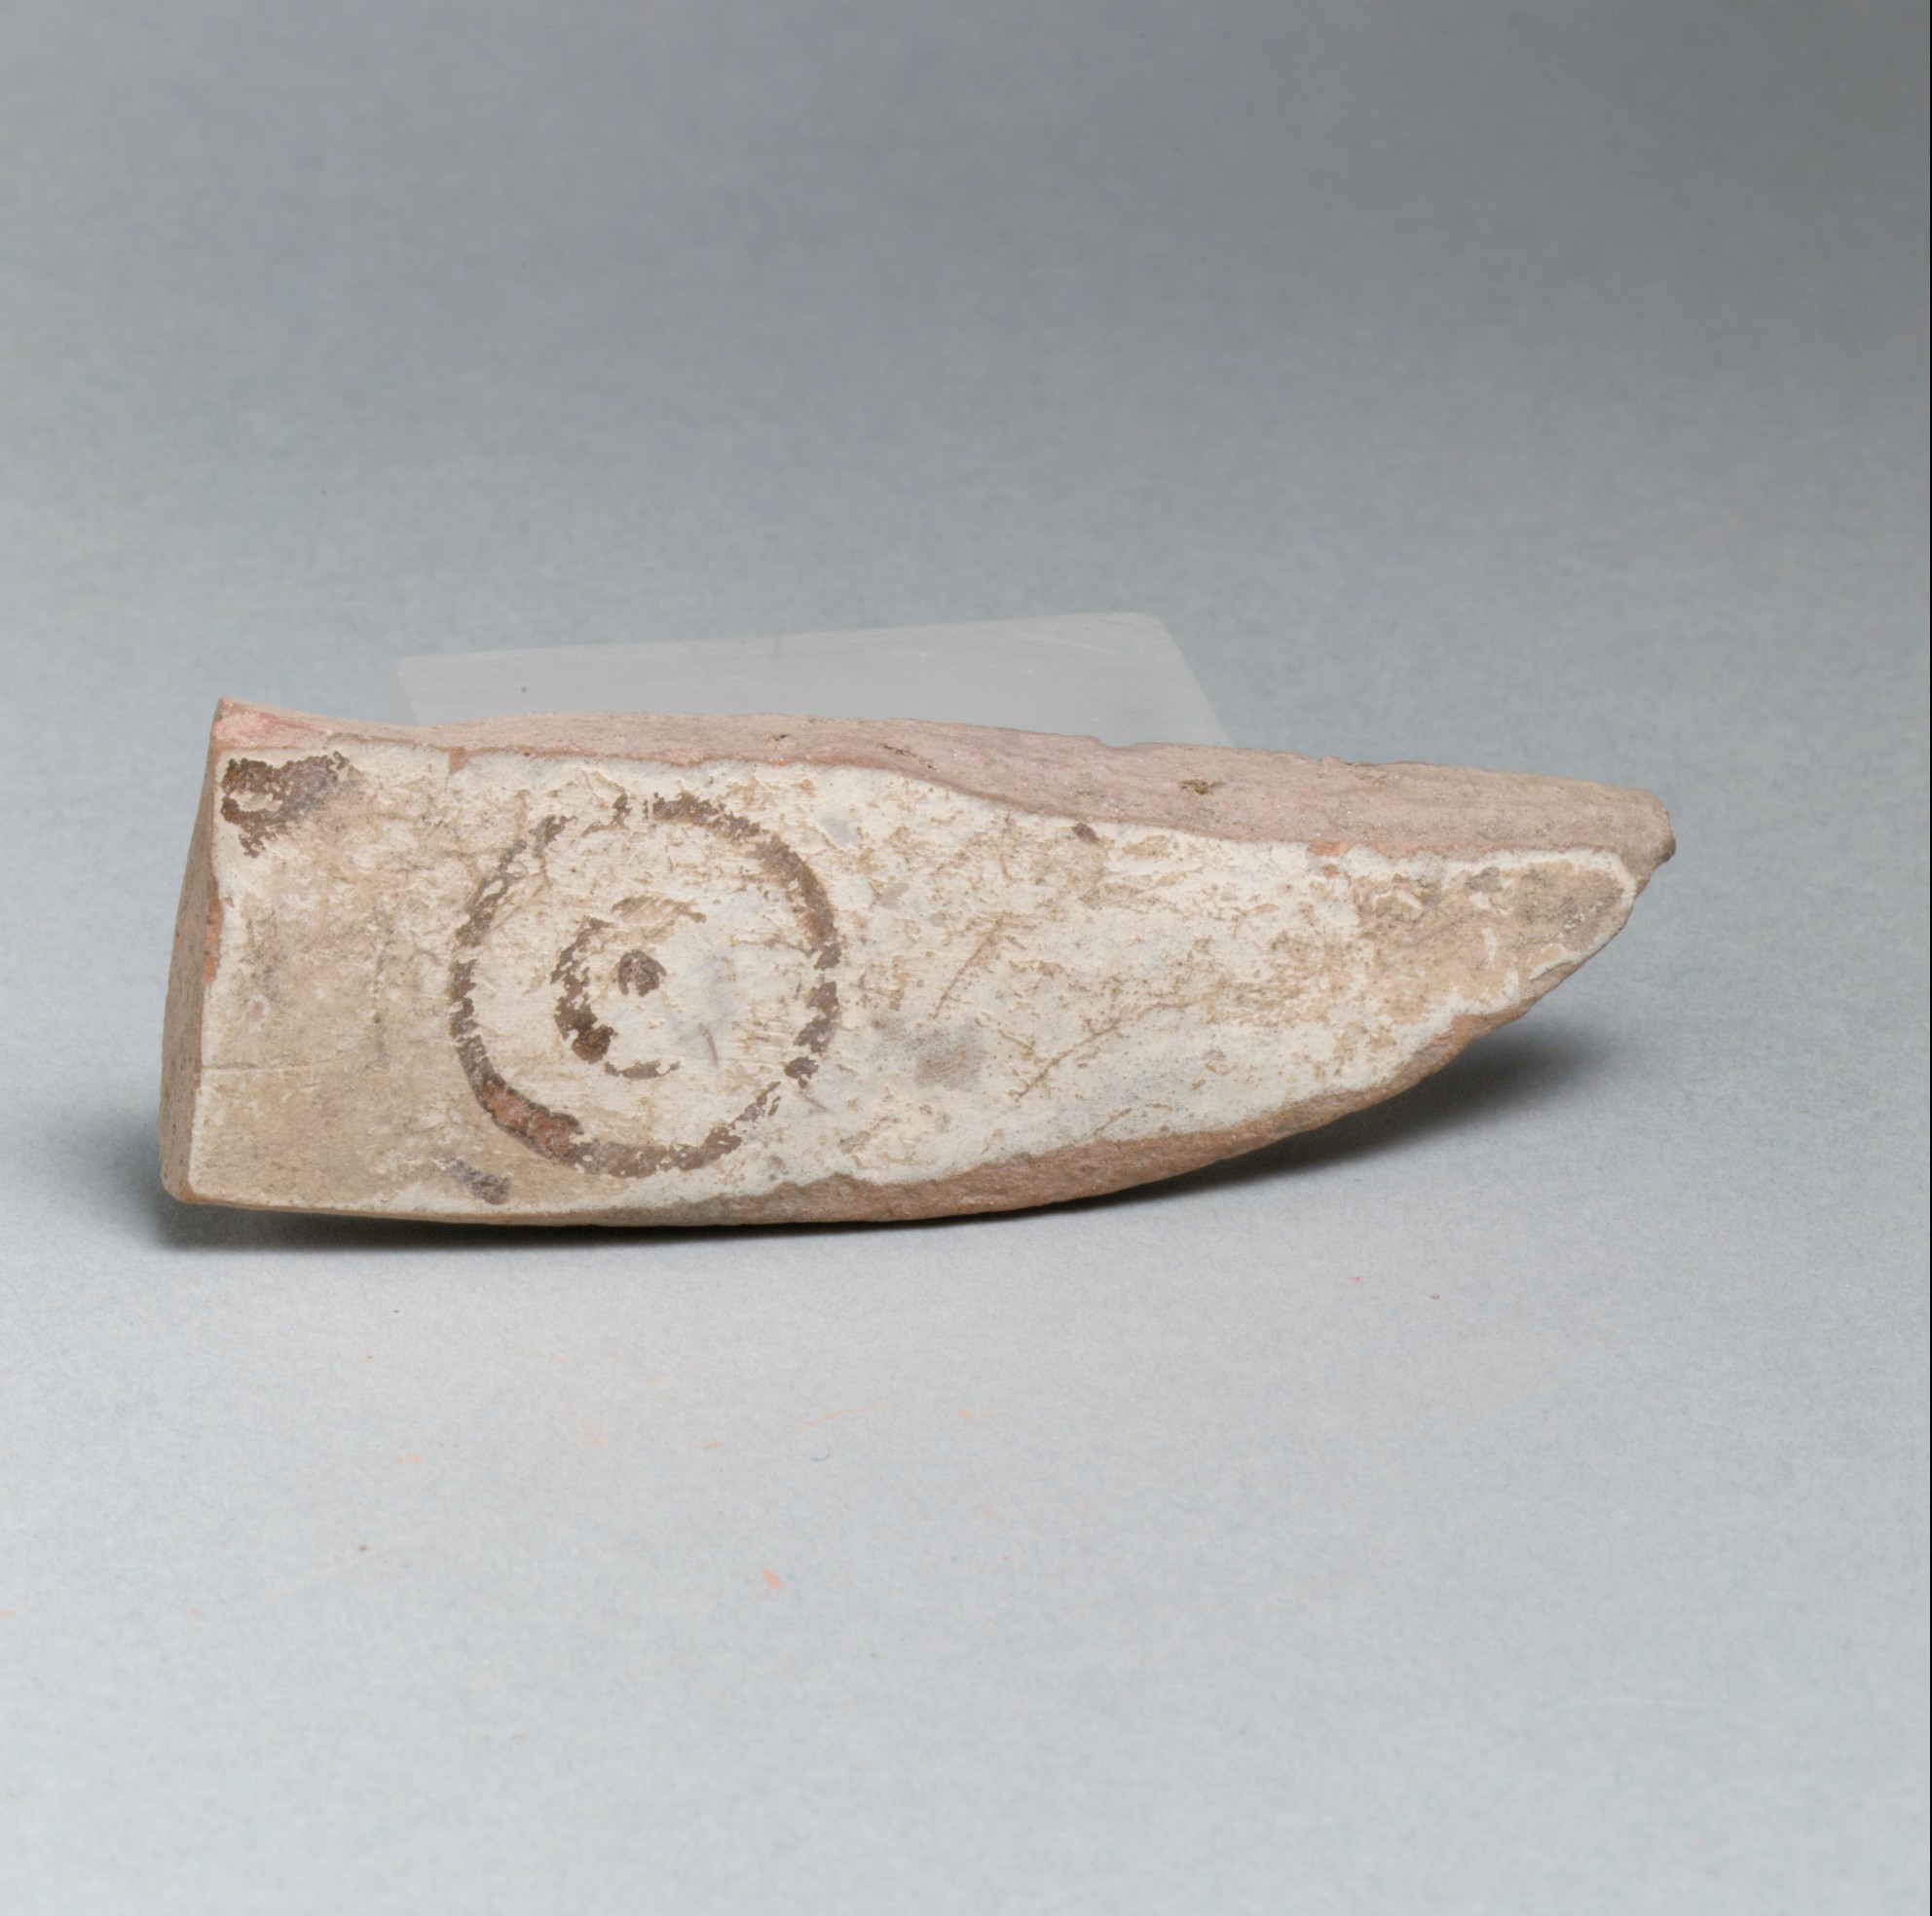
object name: vase fragment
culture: greek or lydian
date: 1050-700 BCE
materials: terracotta